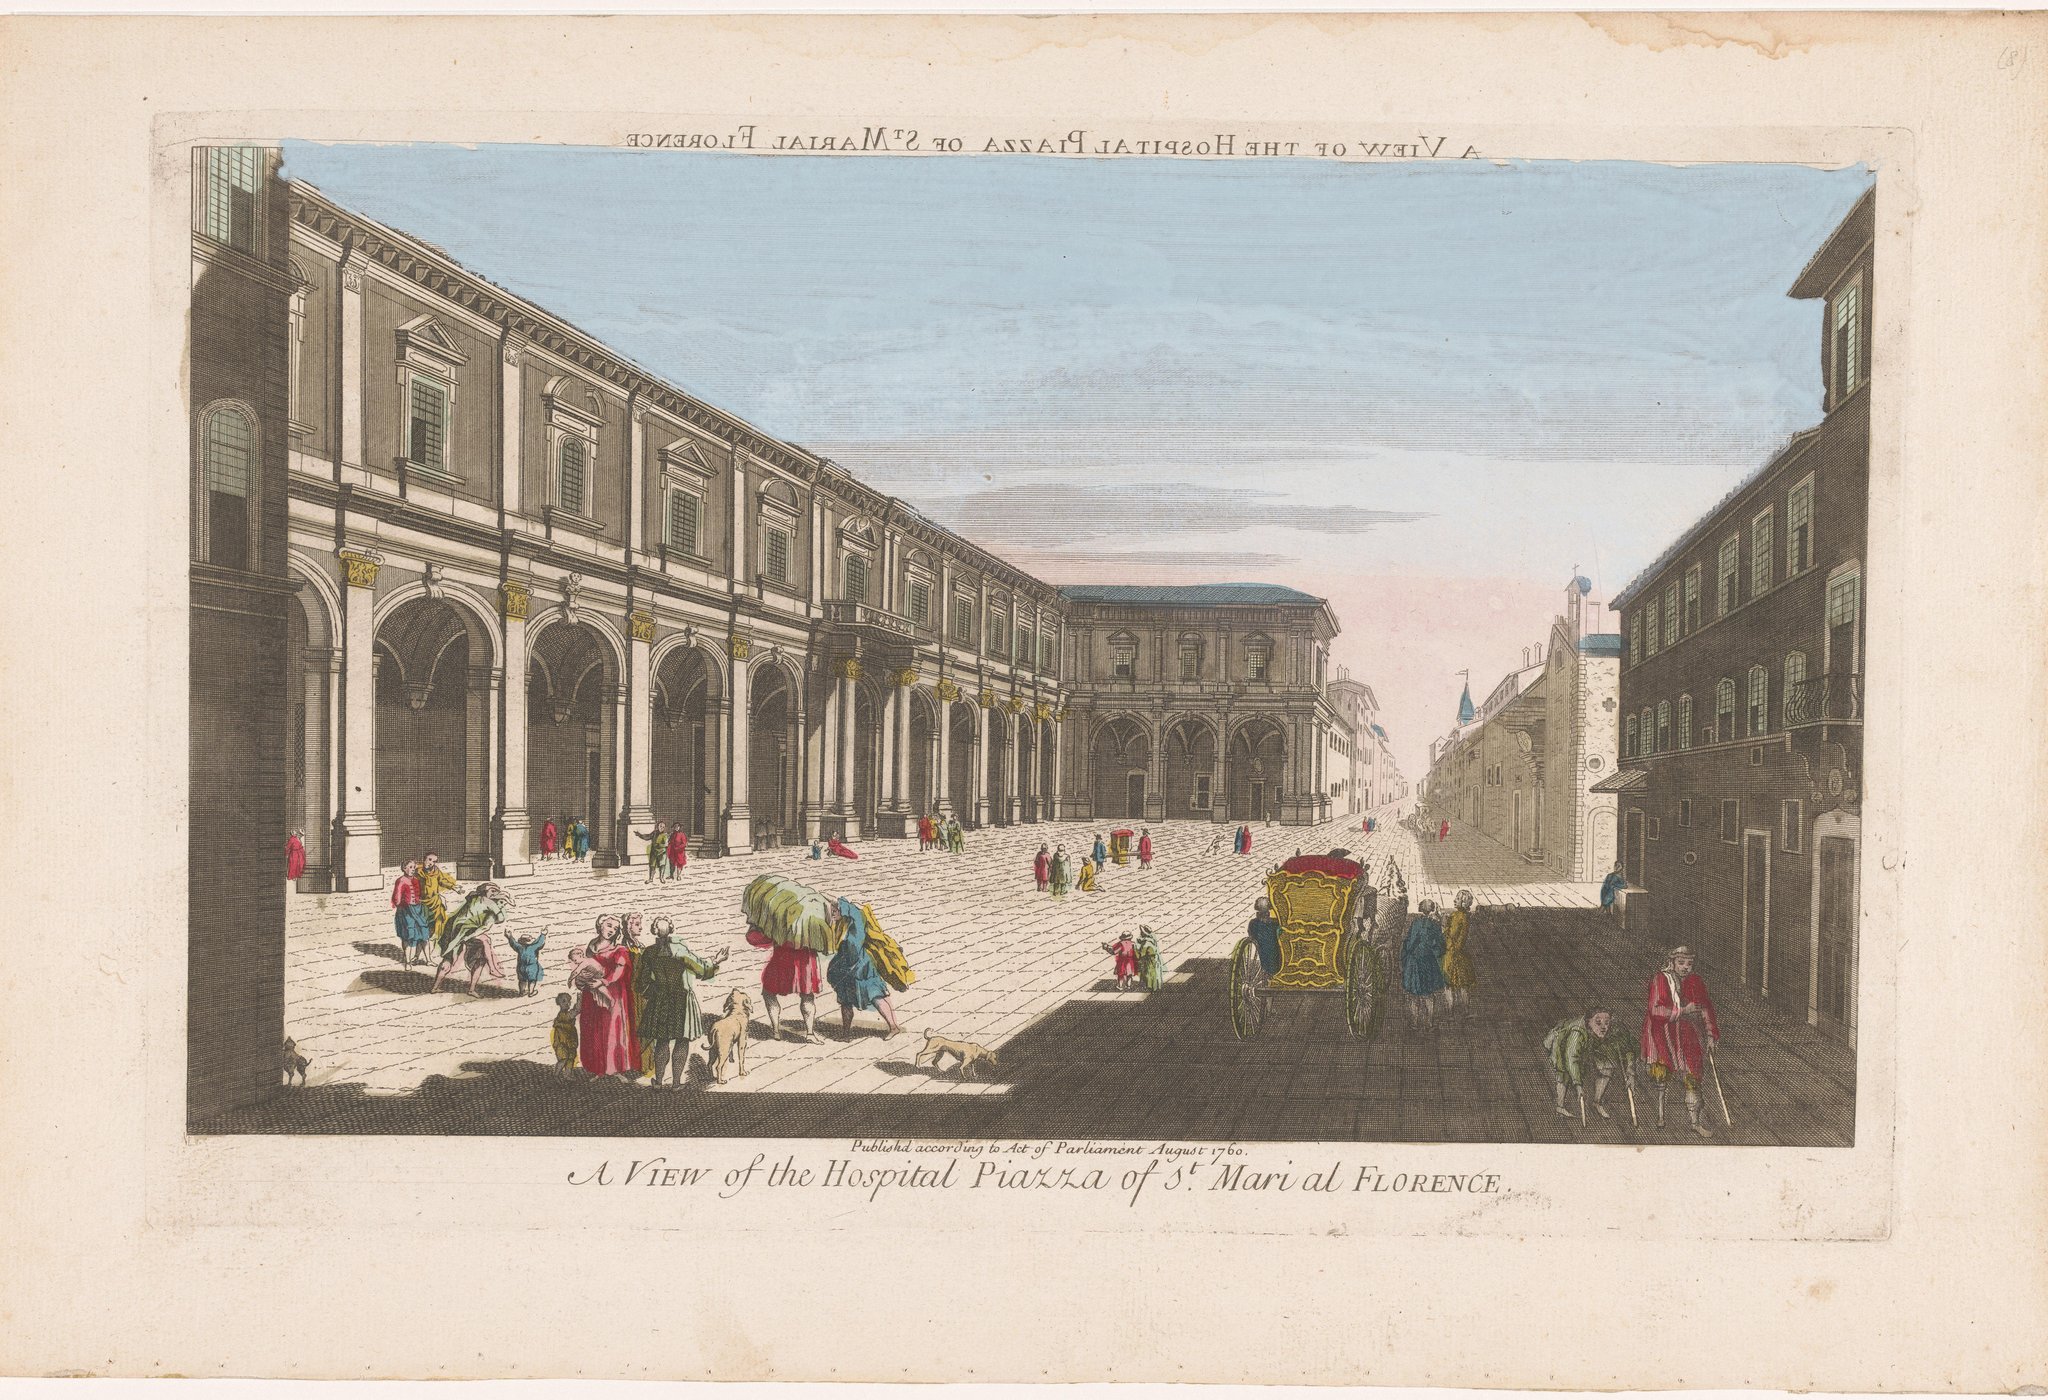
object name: print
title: A view of the Hospital Piazza of St. Mari al Florence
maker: Anonymous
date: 1708-1760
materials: paper, watercolor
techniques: brush, etching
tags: hospital, square, place, circus, etc. (+ city(-scape) with figures, staffage)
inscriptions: watermark:, collector's mark: Lugt 2166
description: De datering is mogelijk deels mee gekopieerd.